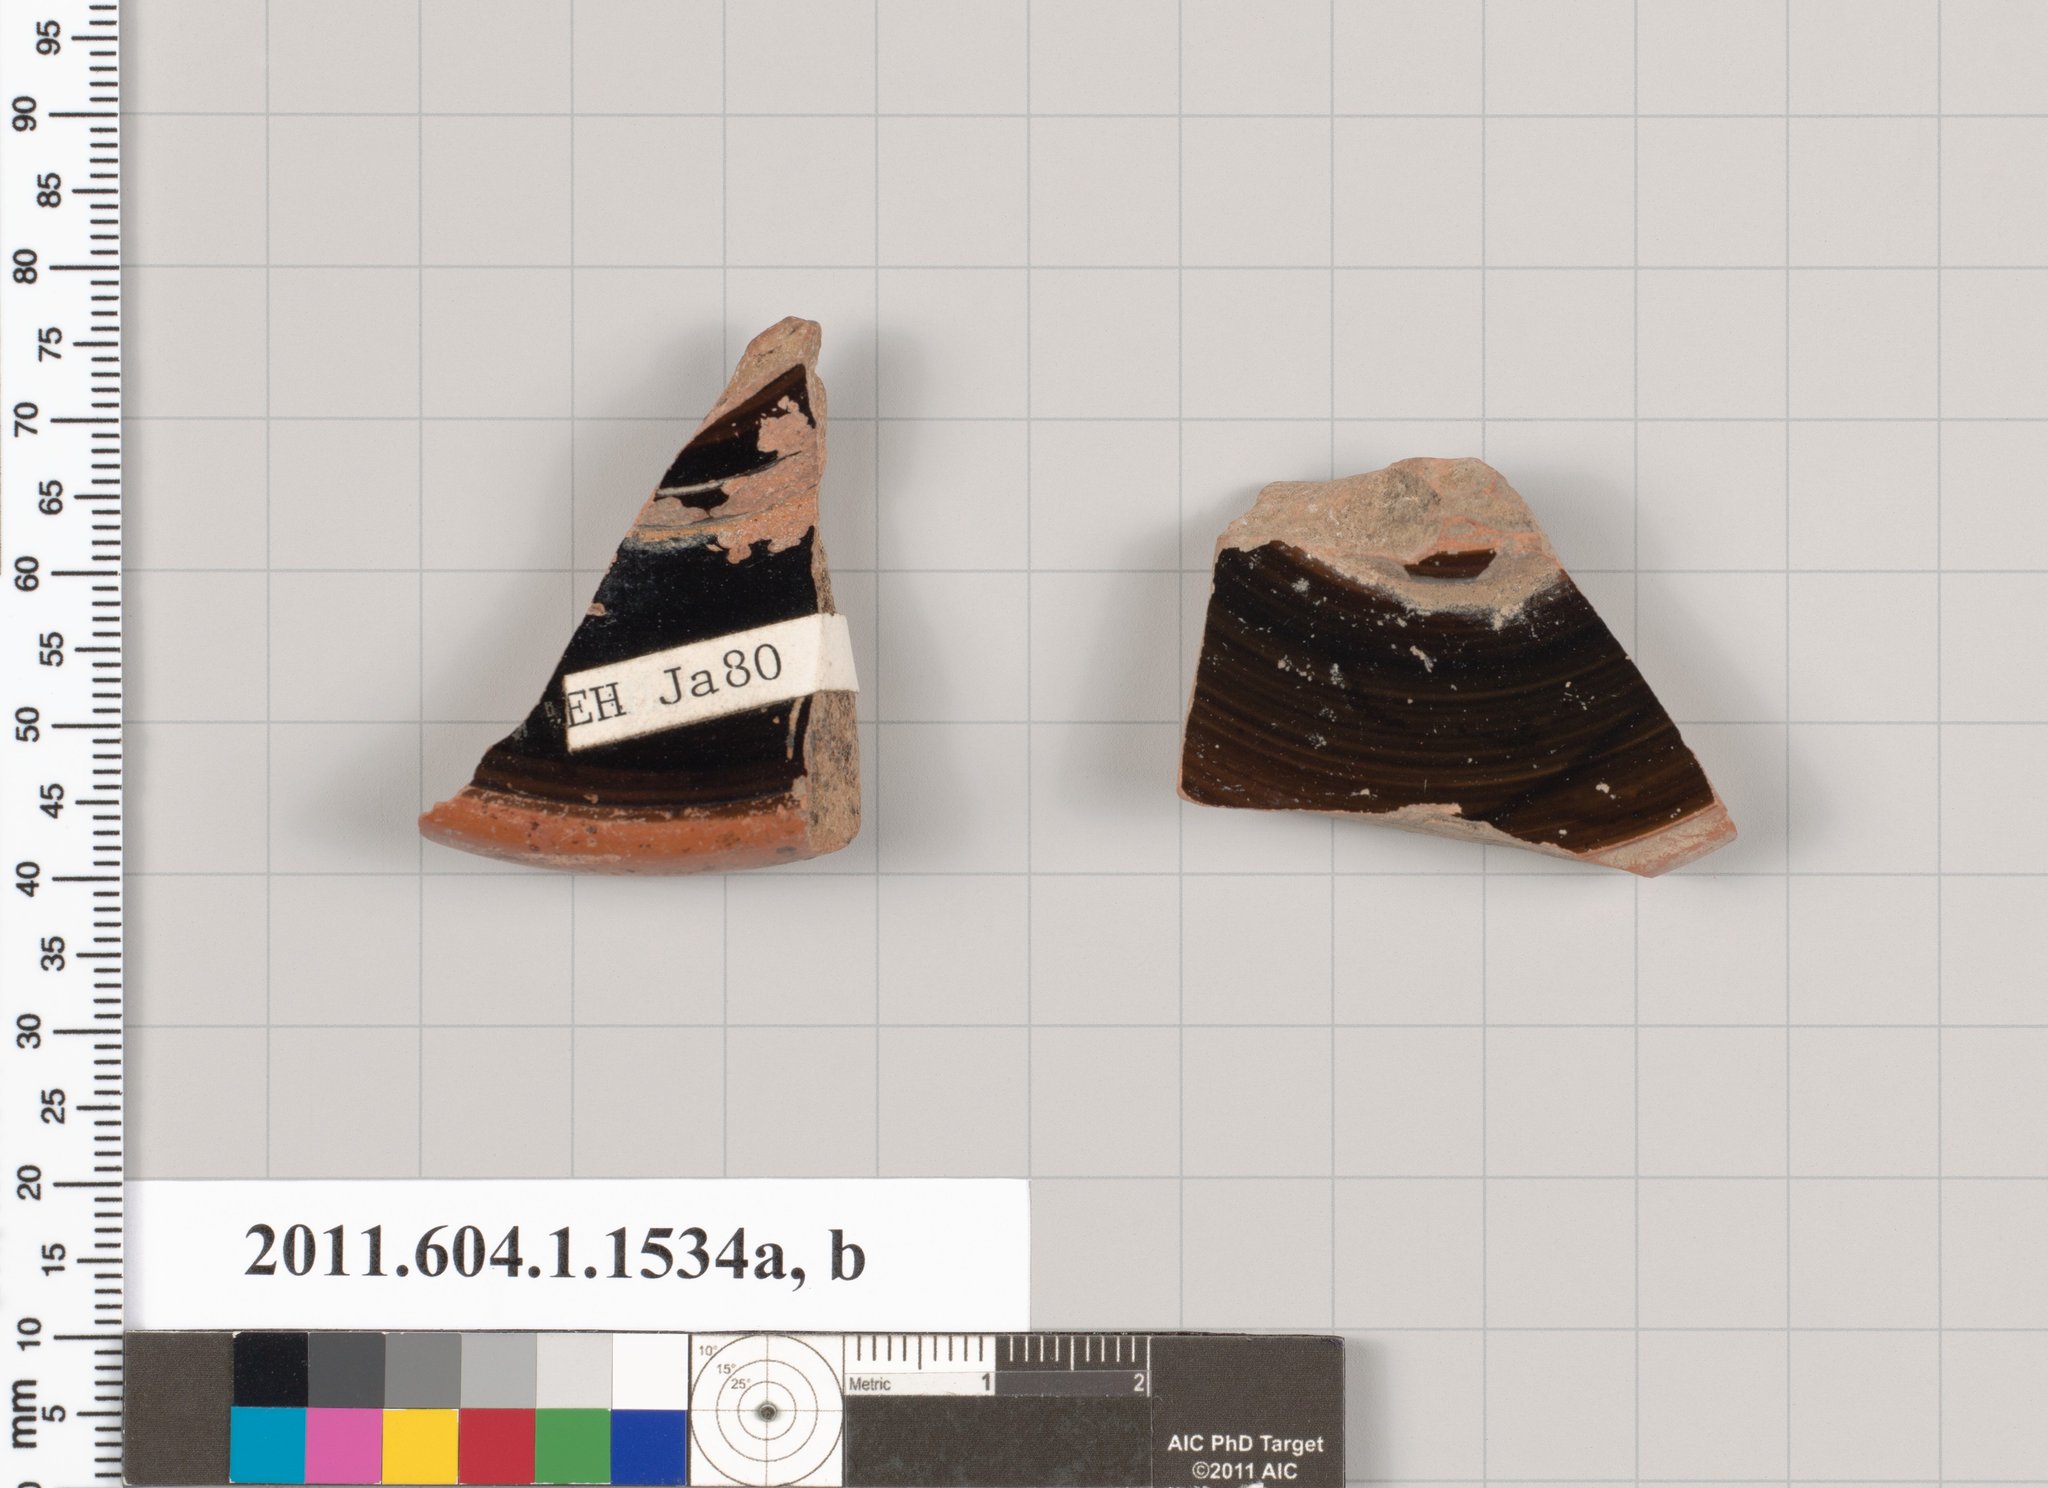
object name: kylix fragment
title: Terracotta fragments of kylikes (drinking cups)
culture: greek, attic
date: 500-401 BCE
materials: terracotta